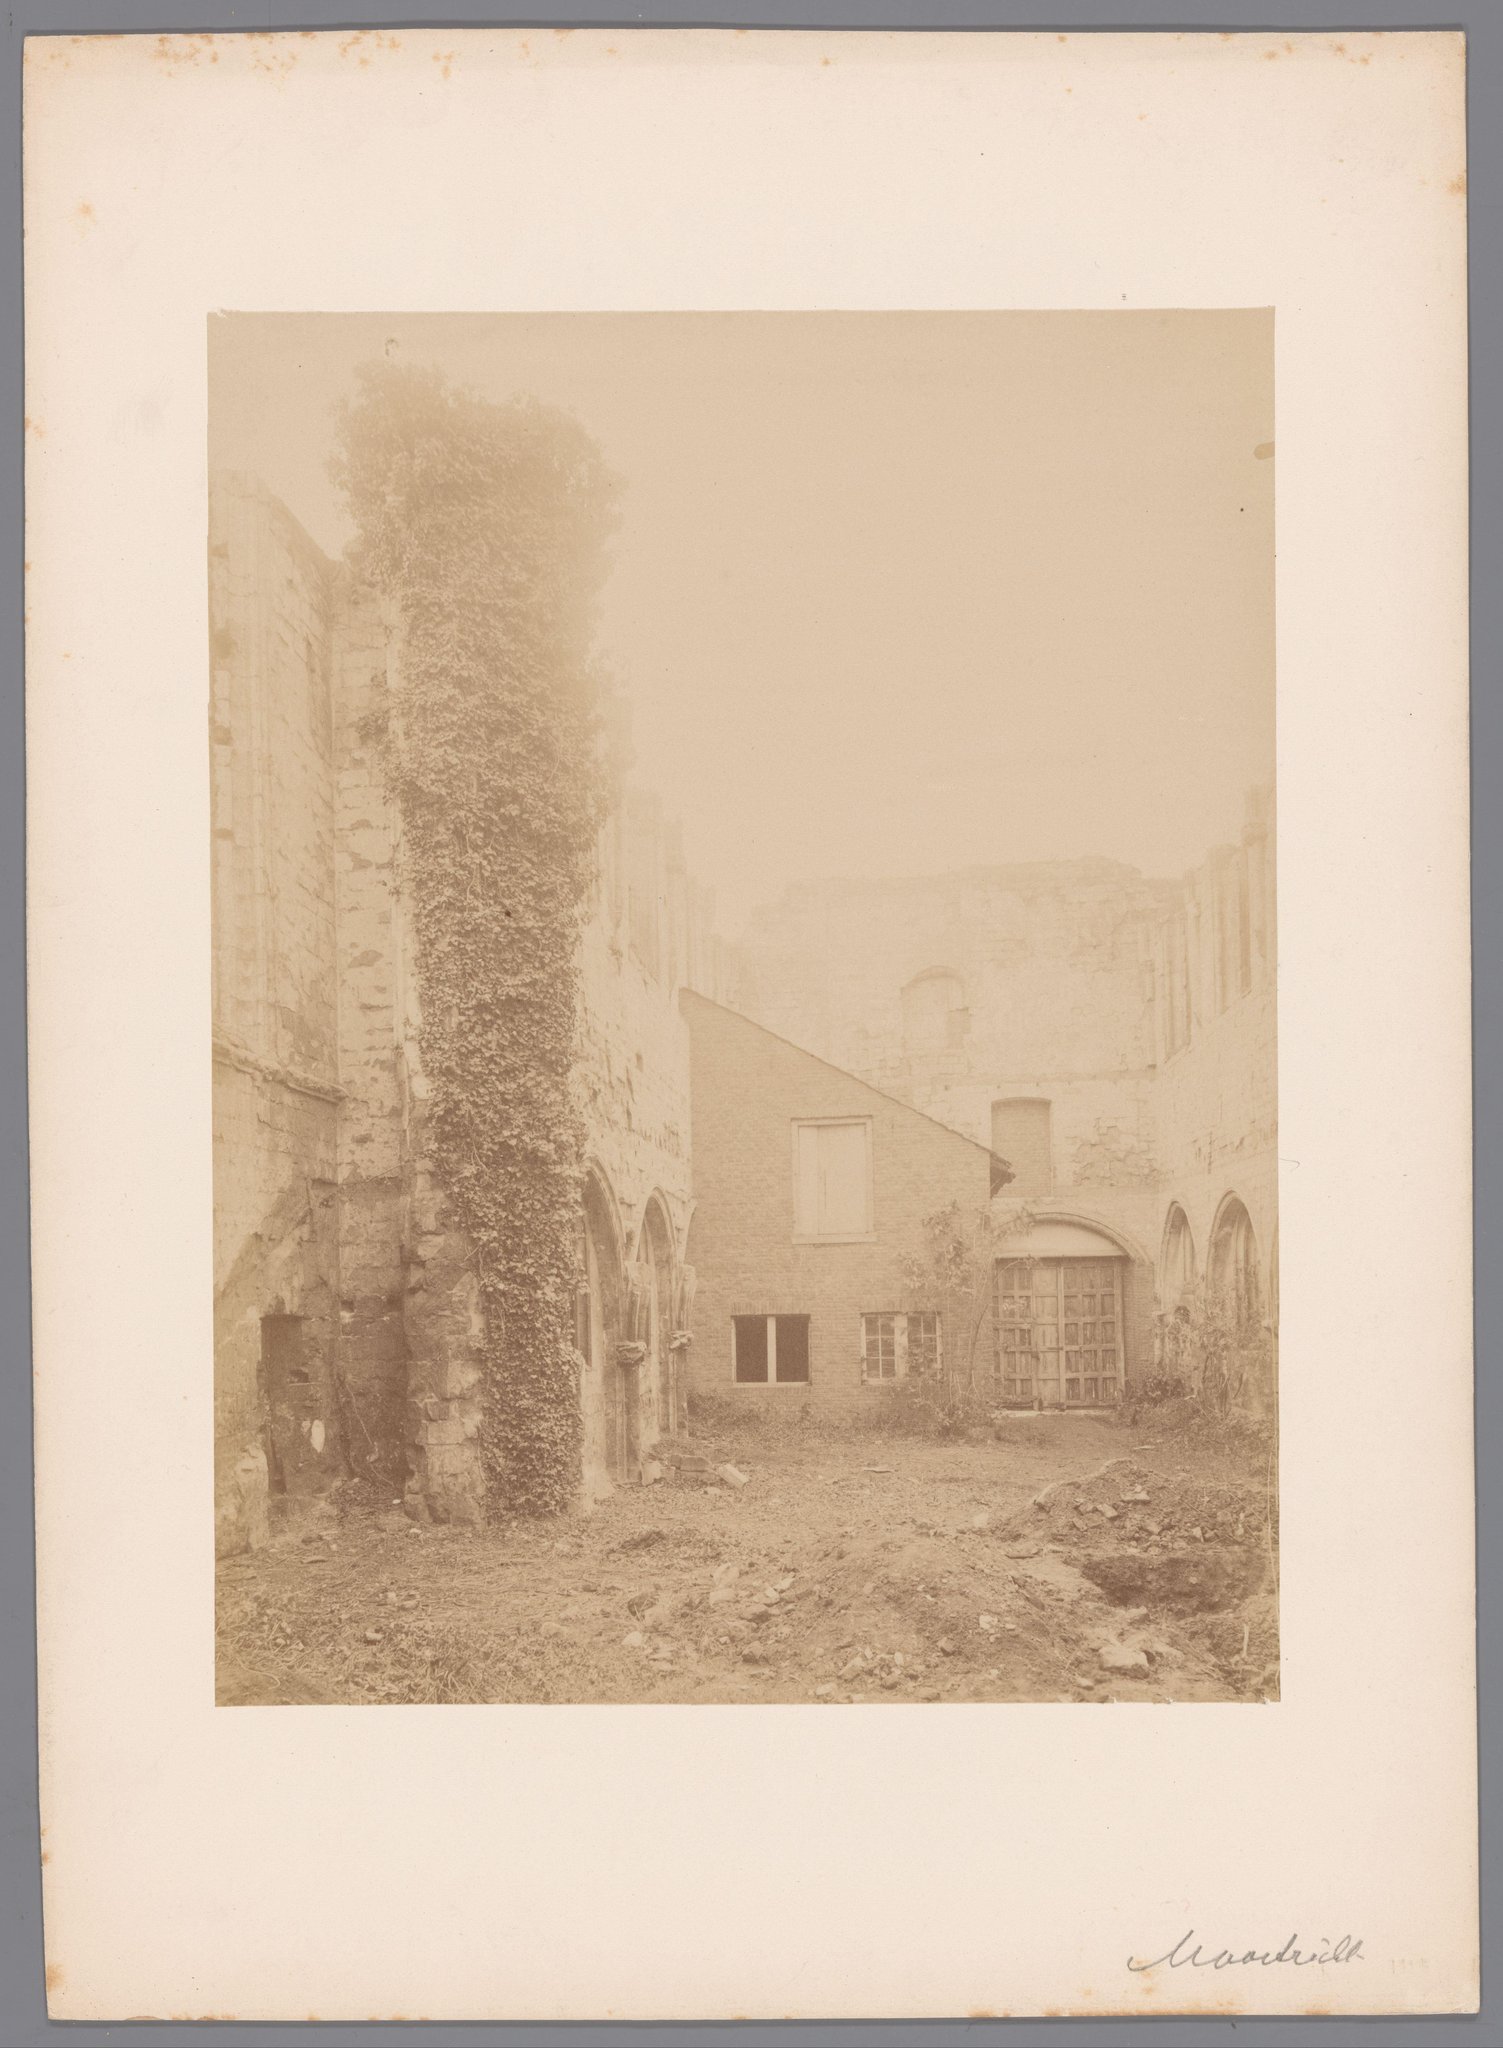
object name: photograph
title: Gezicht op het schip van de kerk bij het oude Beyart klooster te Maastricht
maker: anoniem (monumentenzorg)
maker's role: fotograaf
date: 1893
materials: cardboard, photographic support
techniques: albumen print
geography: maastricht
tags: ruin of church, monastery, etc.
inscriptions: annotation: ‘Maastricht’, annotation: ‘Maastricht (L.)/ Beyaertgebouwen/ ht schip der kerk gezien van uit het koor/ Nov 1893’